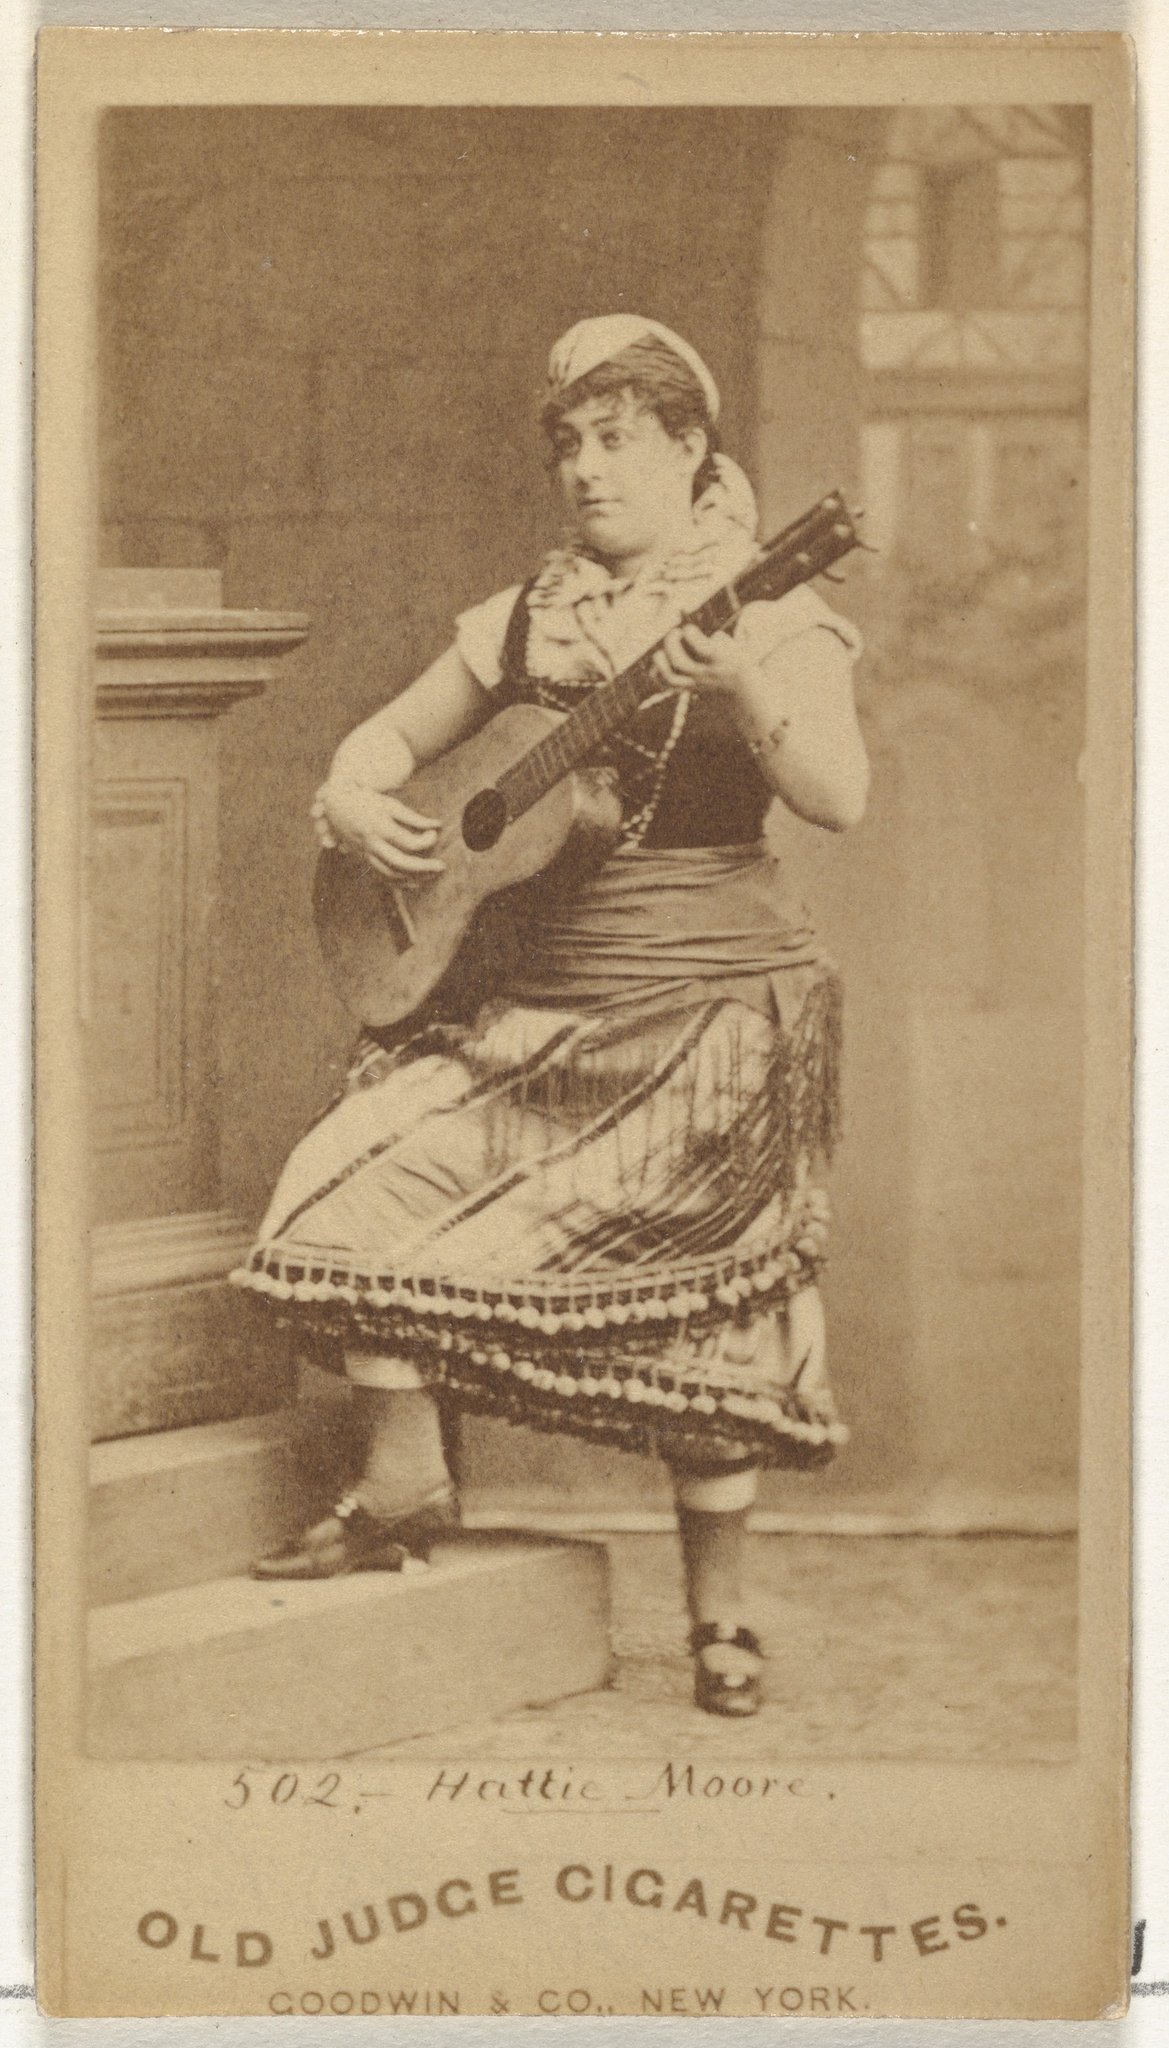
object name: photograph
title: Hattie Moore, from the Actors and Actresses series (N171) for Old Judge Cigarettes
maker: goodwin & company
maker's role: publisher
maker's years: 1850-1950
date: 1886-1890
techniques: albumen silver print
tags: portraits,women,guitars,actresses